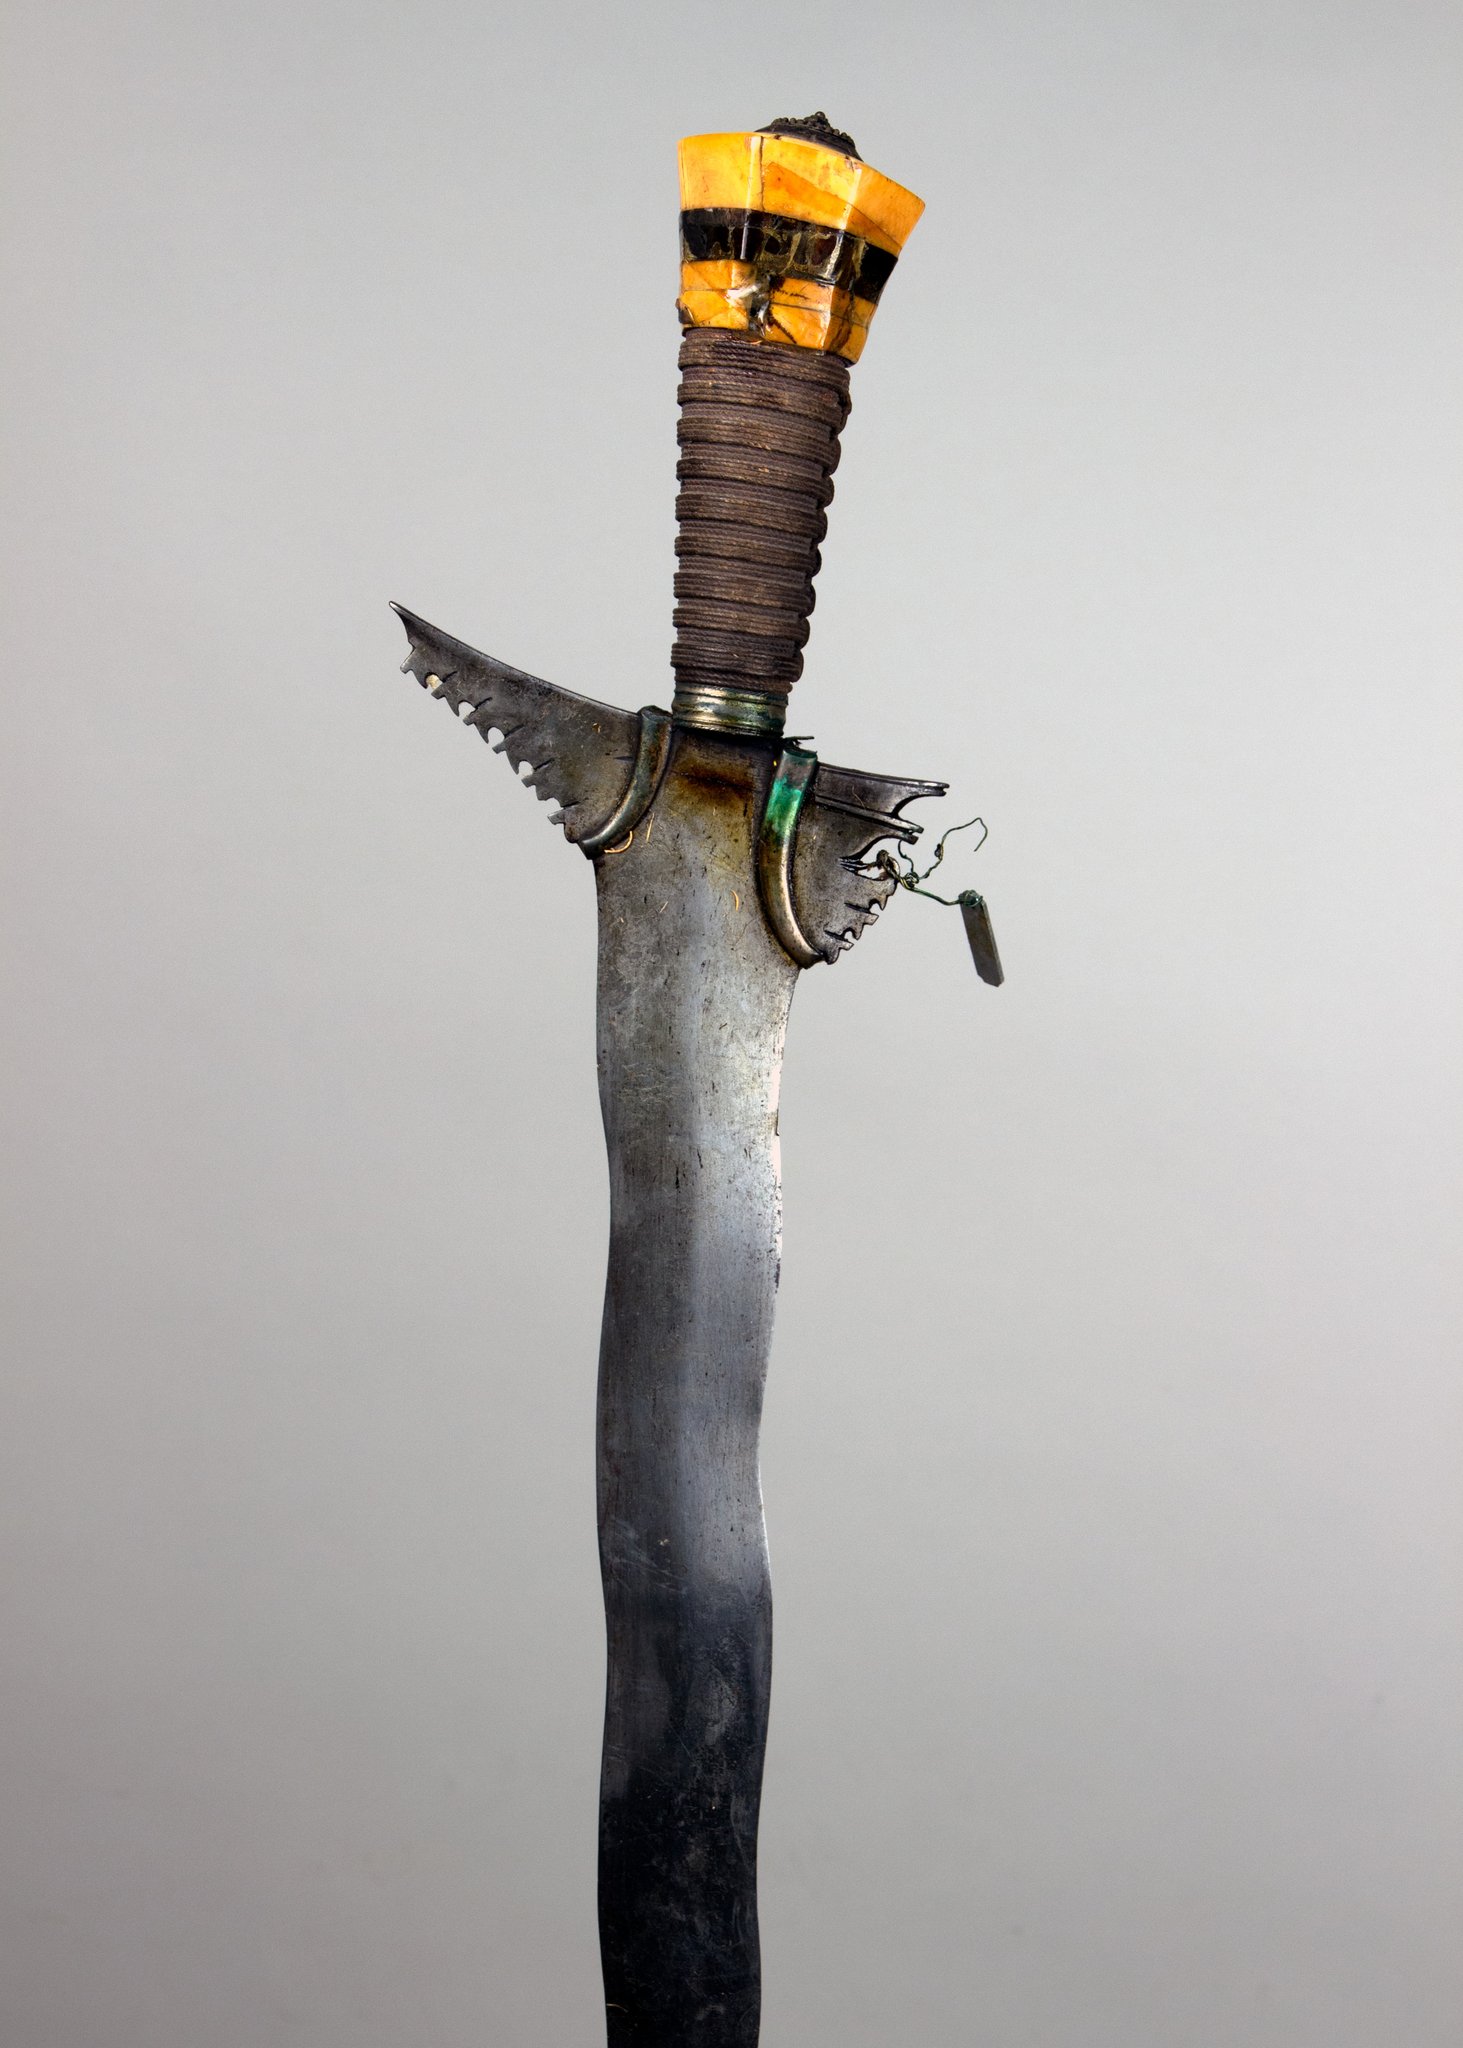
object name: kris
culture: philippine, jolo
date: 1701-1900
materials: cord, horn, ivory, silver, steel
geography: philippines